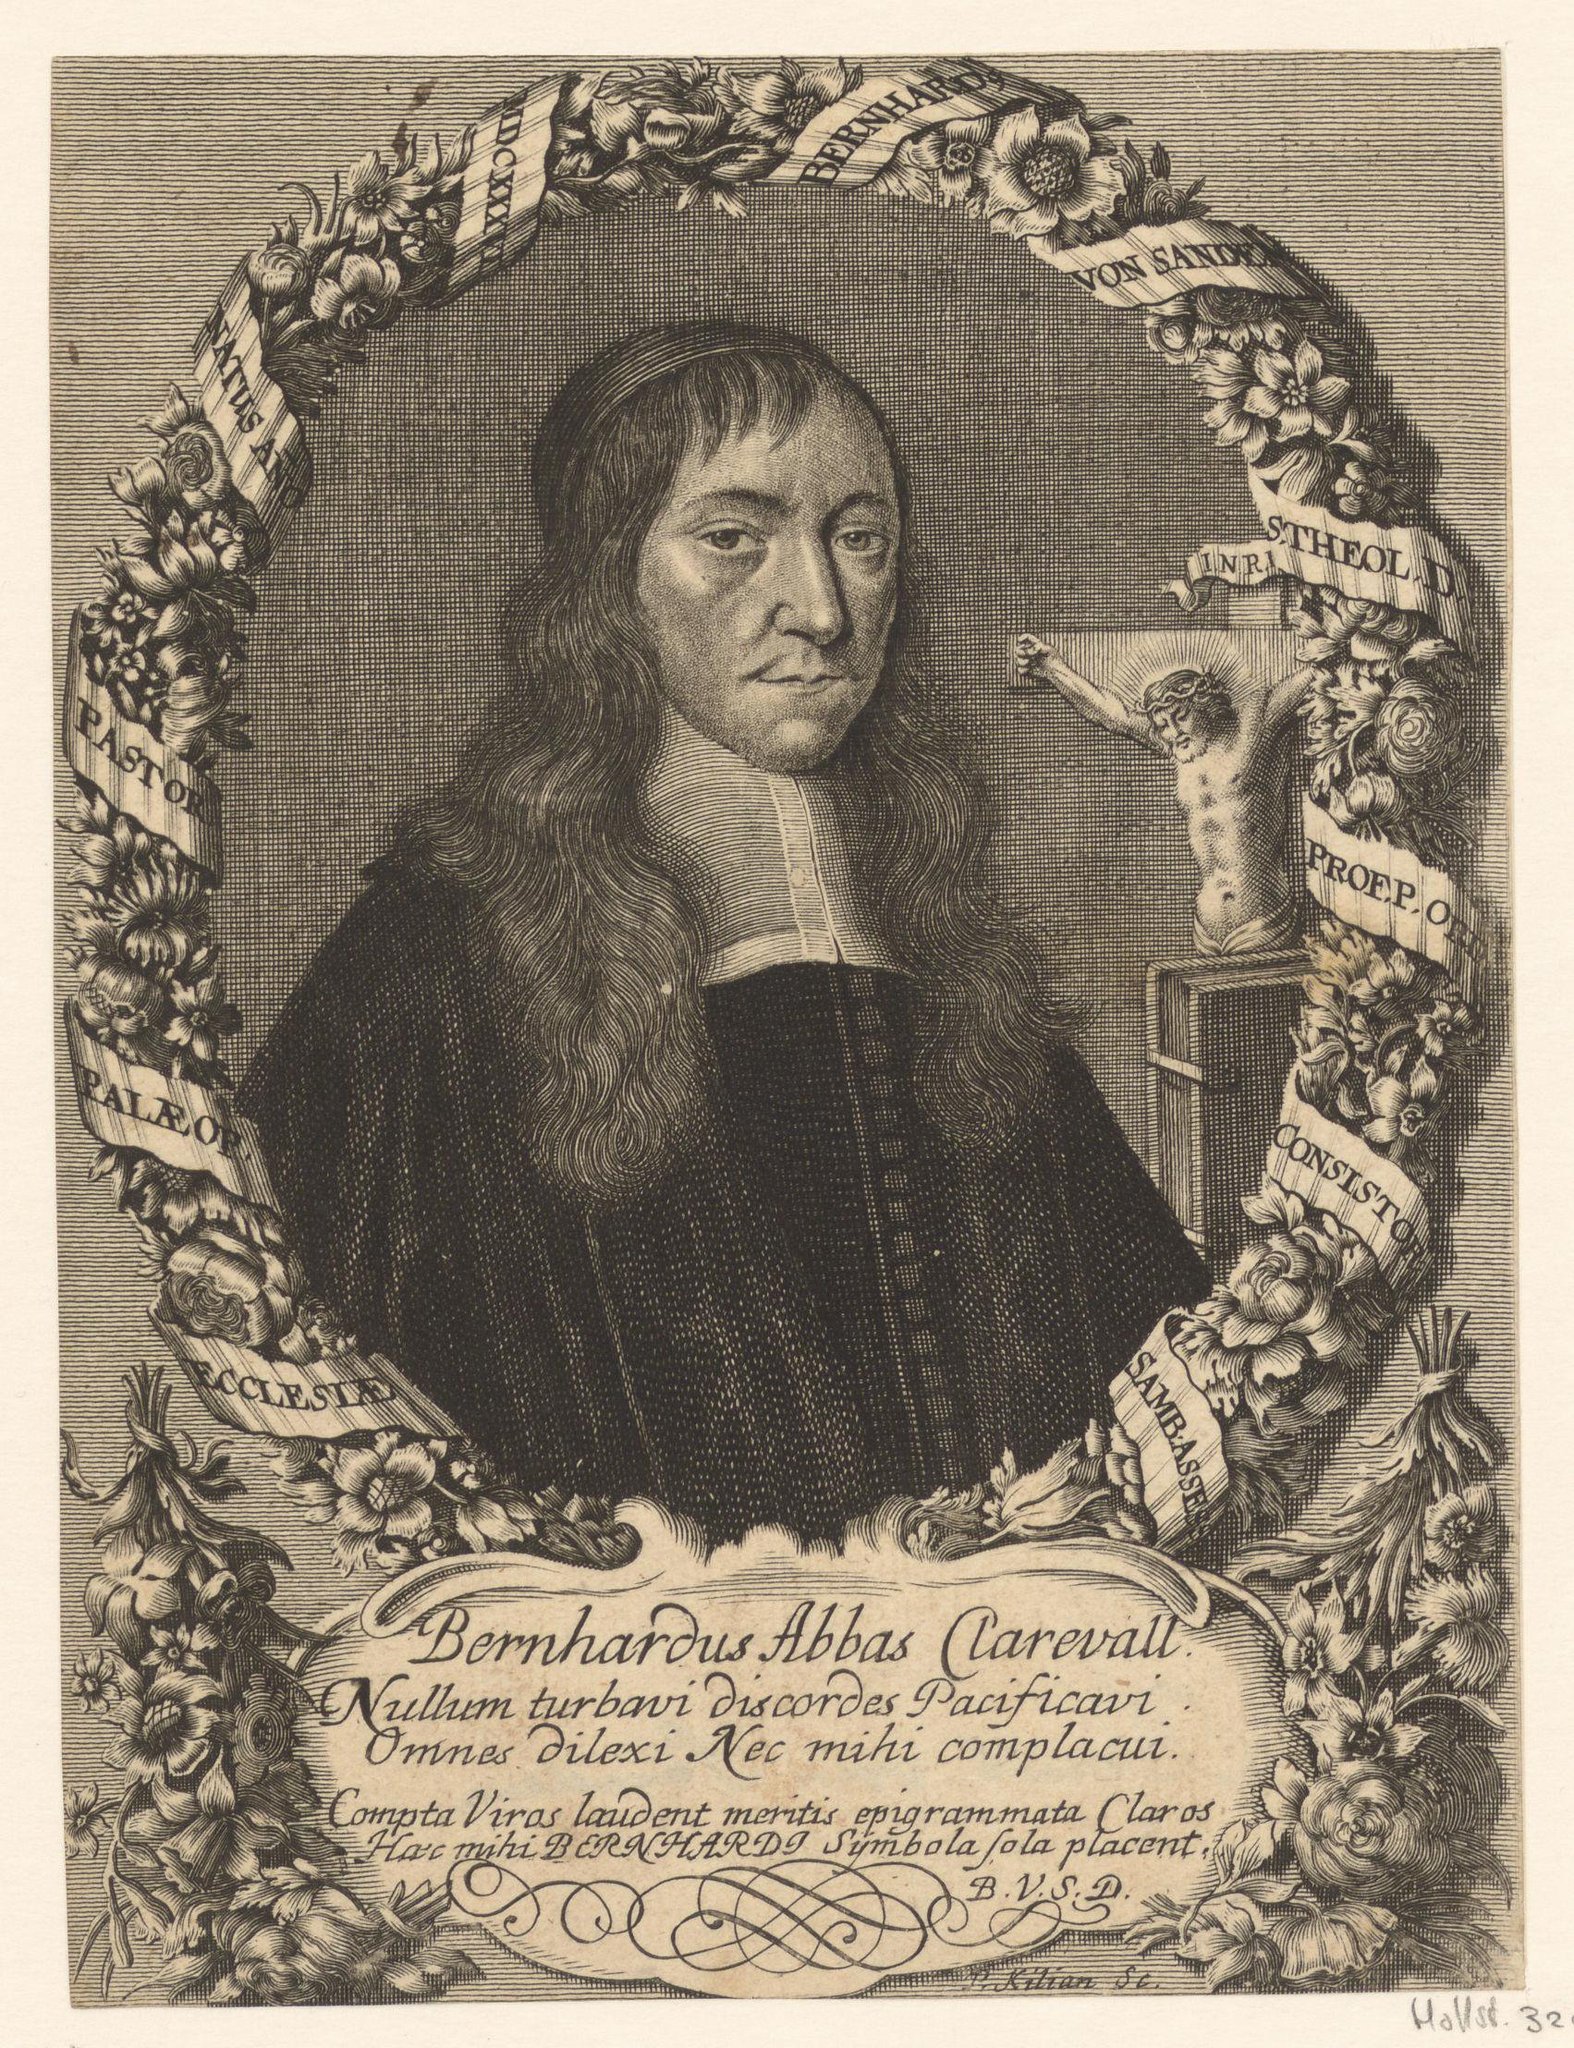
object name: print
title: Portret van Bernhard von Sanden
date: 1646-1693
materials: paper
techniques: engraving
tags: bernhard von sanden, archbishop, bishop, etc. (roman catholic), theologian, historical persons, crucifix ~ personal devotion, ornament ~ festoon, garland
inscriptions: collector's mark: Lugt 2228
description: Tekst in het Latijn in de banier om de omlijsting van guirlande en in de ondermarge.